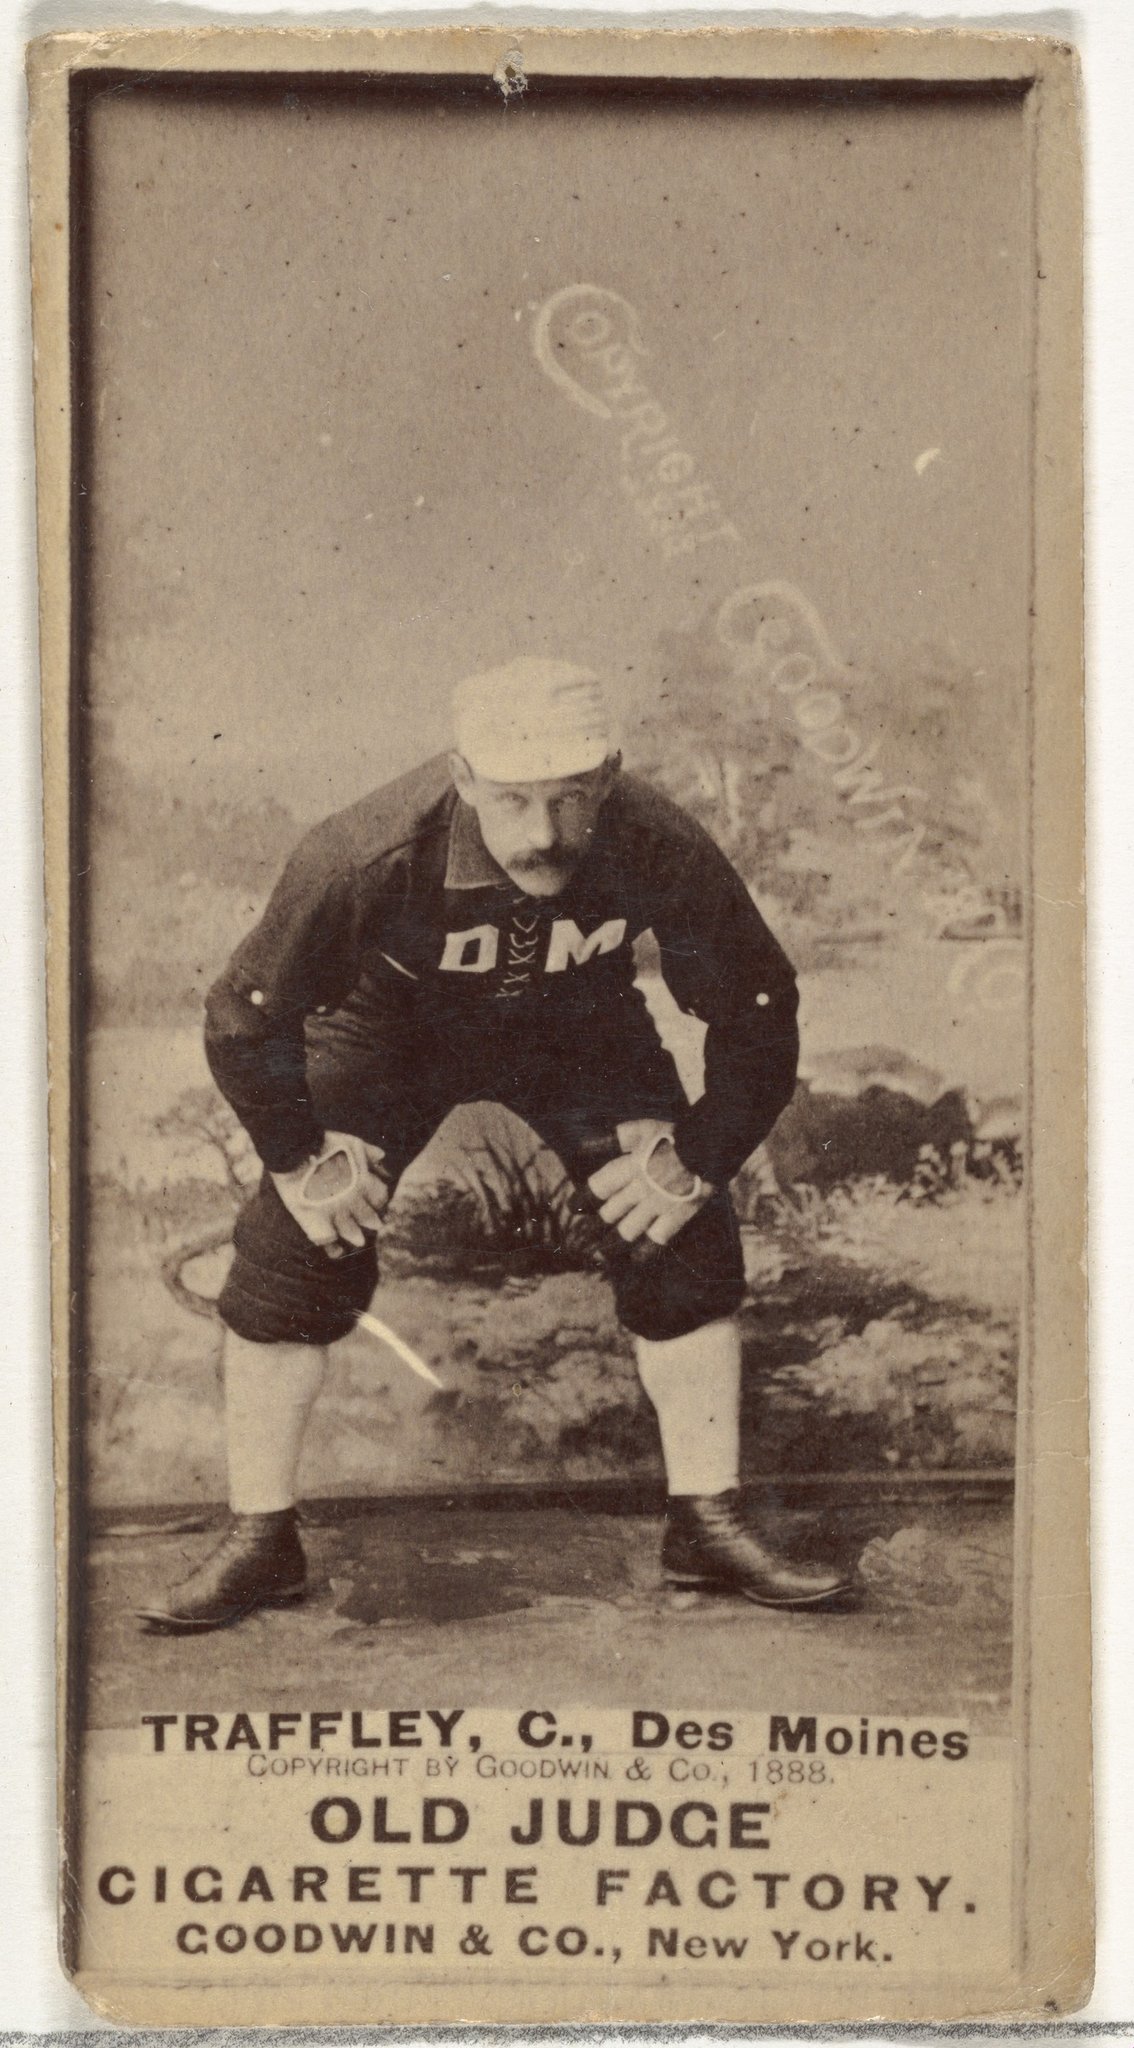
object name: baseball card, photograph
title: William Franklin "Bill" Traffley, Catcher, Des Moines Prohibitionists, from the Old Judge series (N172) for Old Judge Cigarettes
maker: goodwin & company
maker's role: publisher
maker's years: 1850-1950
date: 1888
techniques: albumen silver print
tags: men,portraits,baseball,athletes